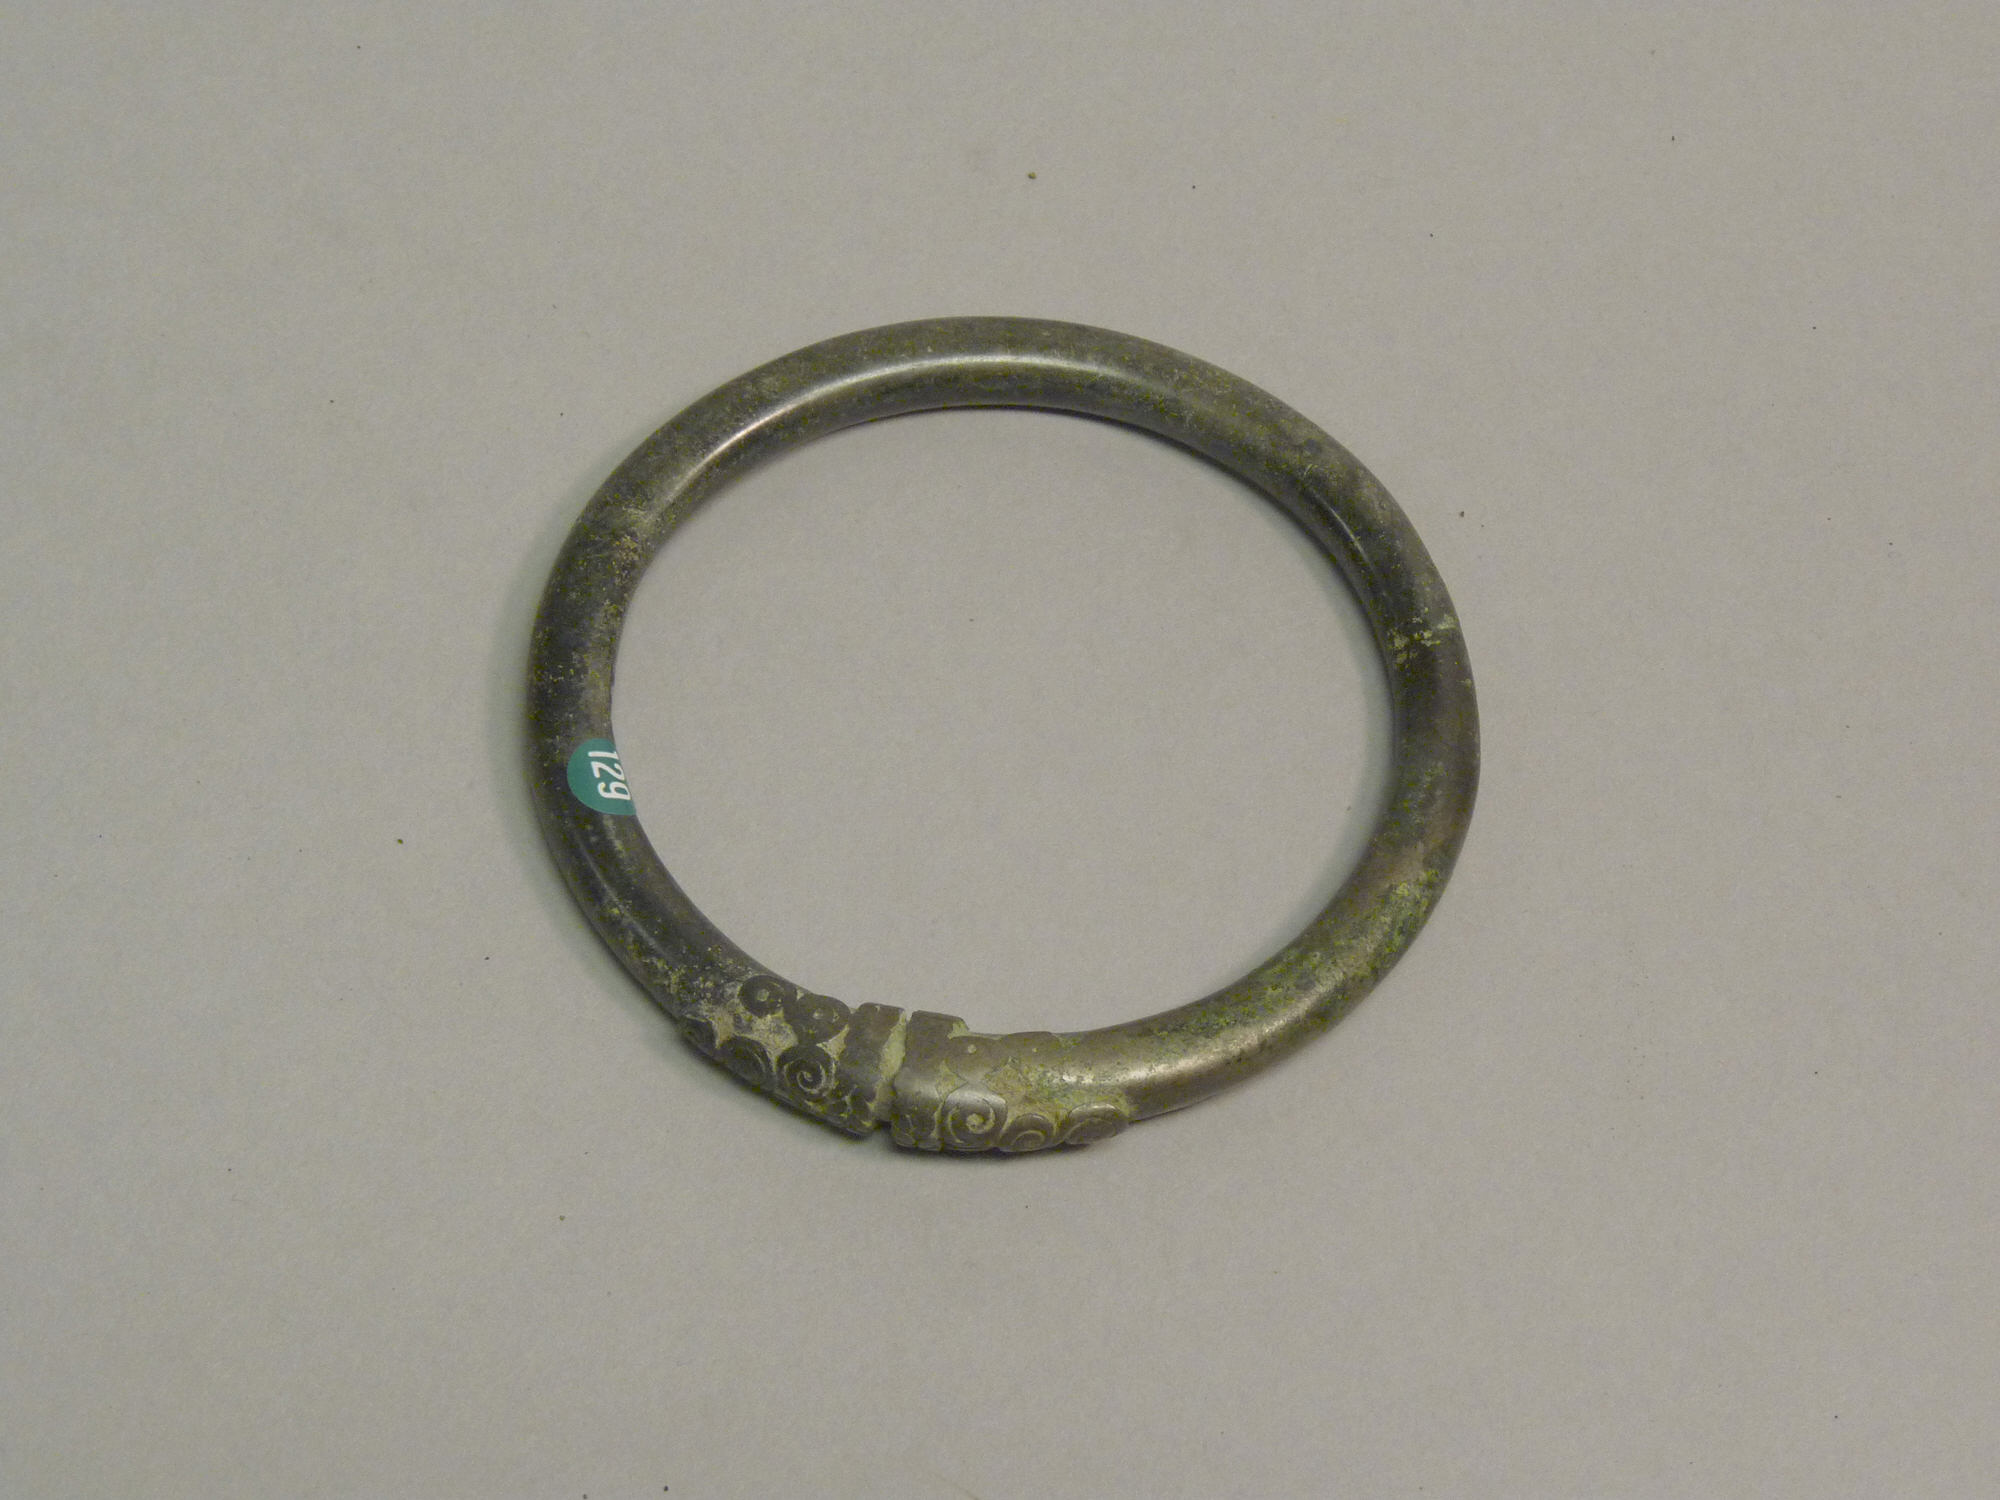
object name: bangle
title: Solid Open Bangle with Decorated Ends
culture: vietnamese, north, highlands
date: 500 BCE-300 CE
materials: bronze